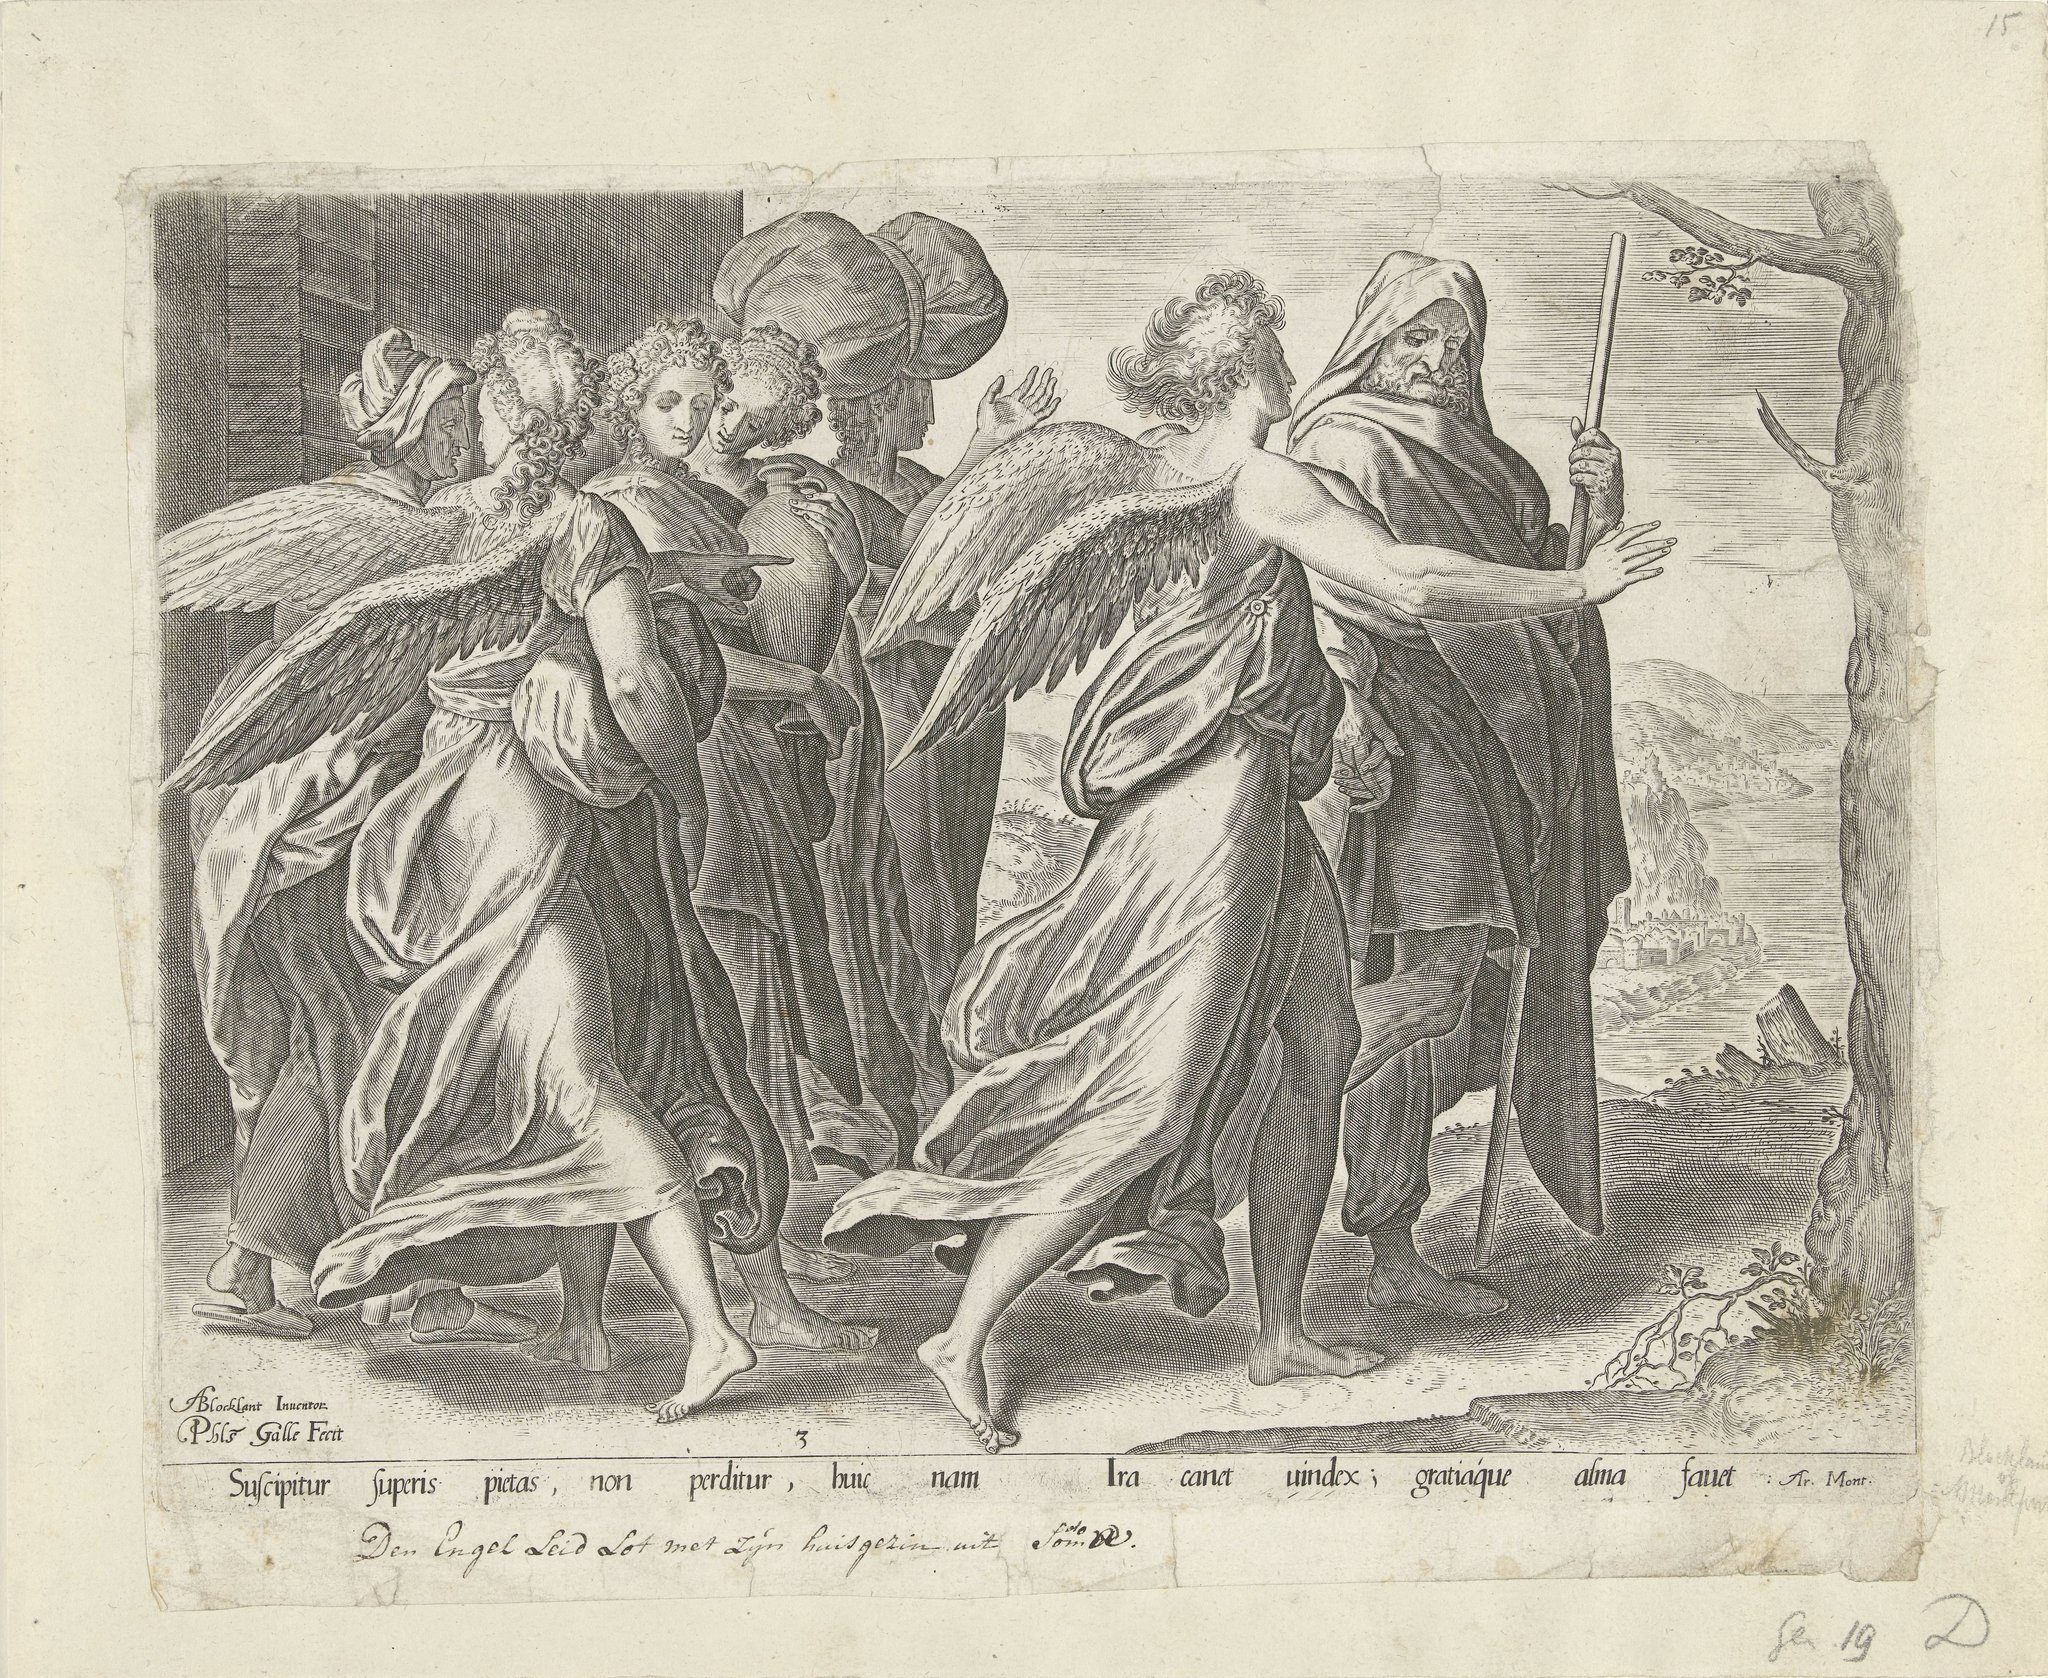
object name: print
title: De engelen leiden Lot en zijn vrouw en dochters uit Sodom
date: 1557-1570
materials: paper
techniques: engraving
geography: haarlem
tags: the angels urge lot to hurry in leaving the city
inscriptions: collector's mark: Lugt 2228, inscription: ‘Den Engel leid Lot met zyn huisgezin uit Sodom’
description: De twee engelen begeleiden Lot en zijn familie de stad uit. Op de achtergrond een heuvelachtig landschap met een rivier.